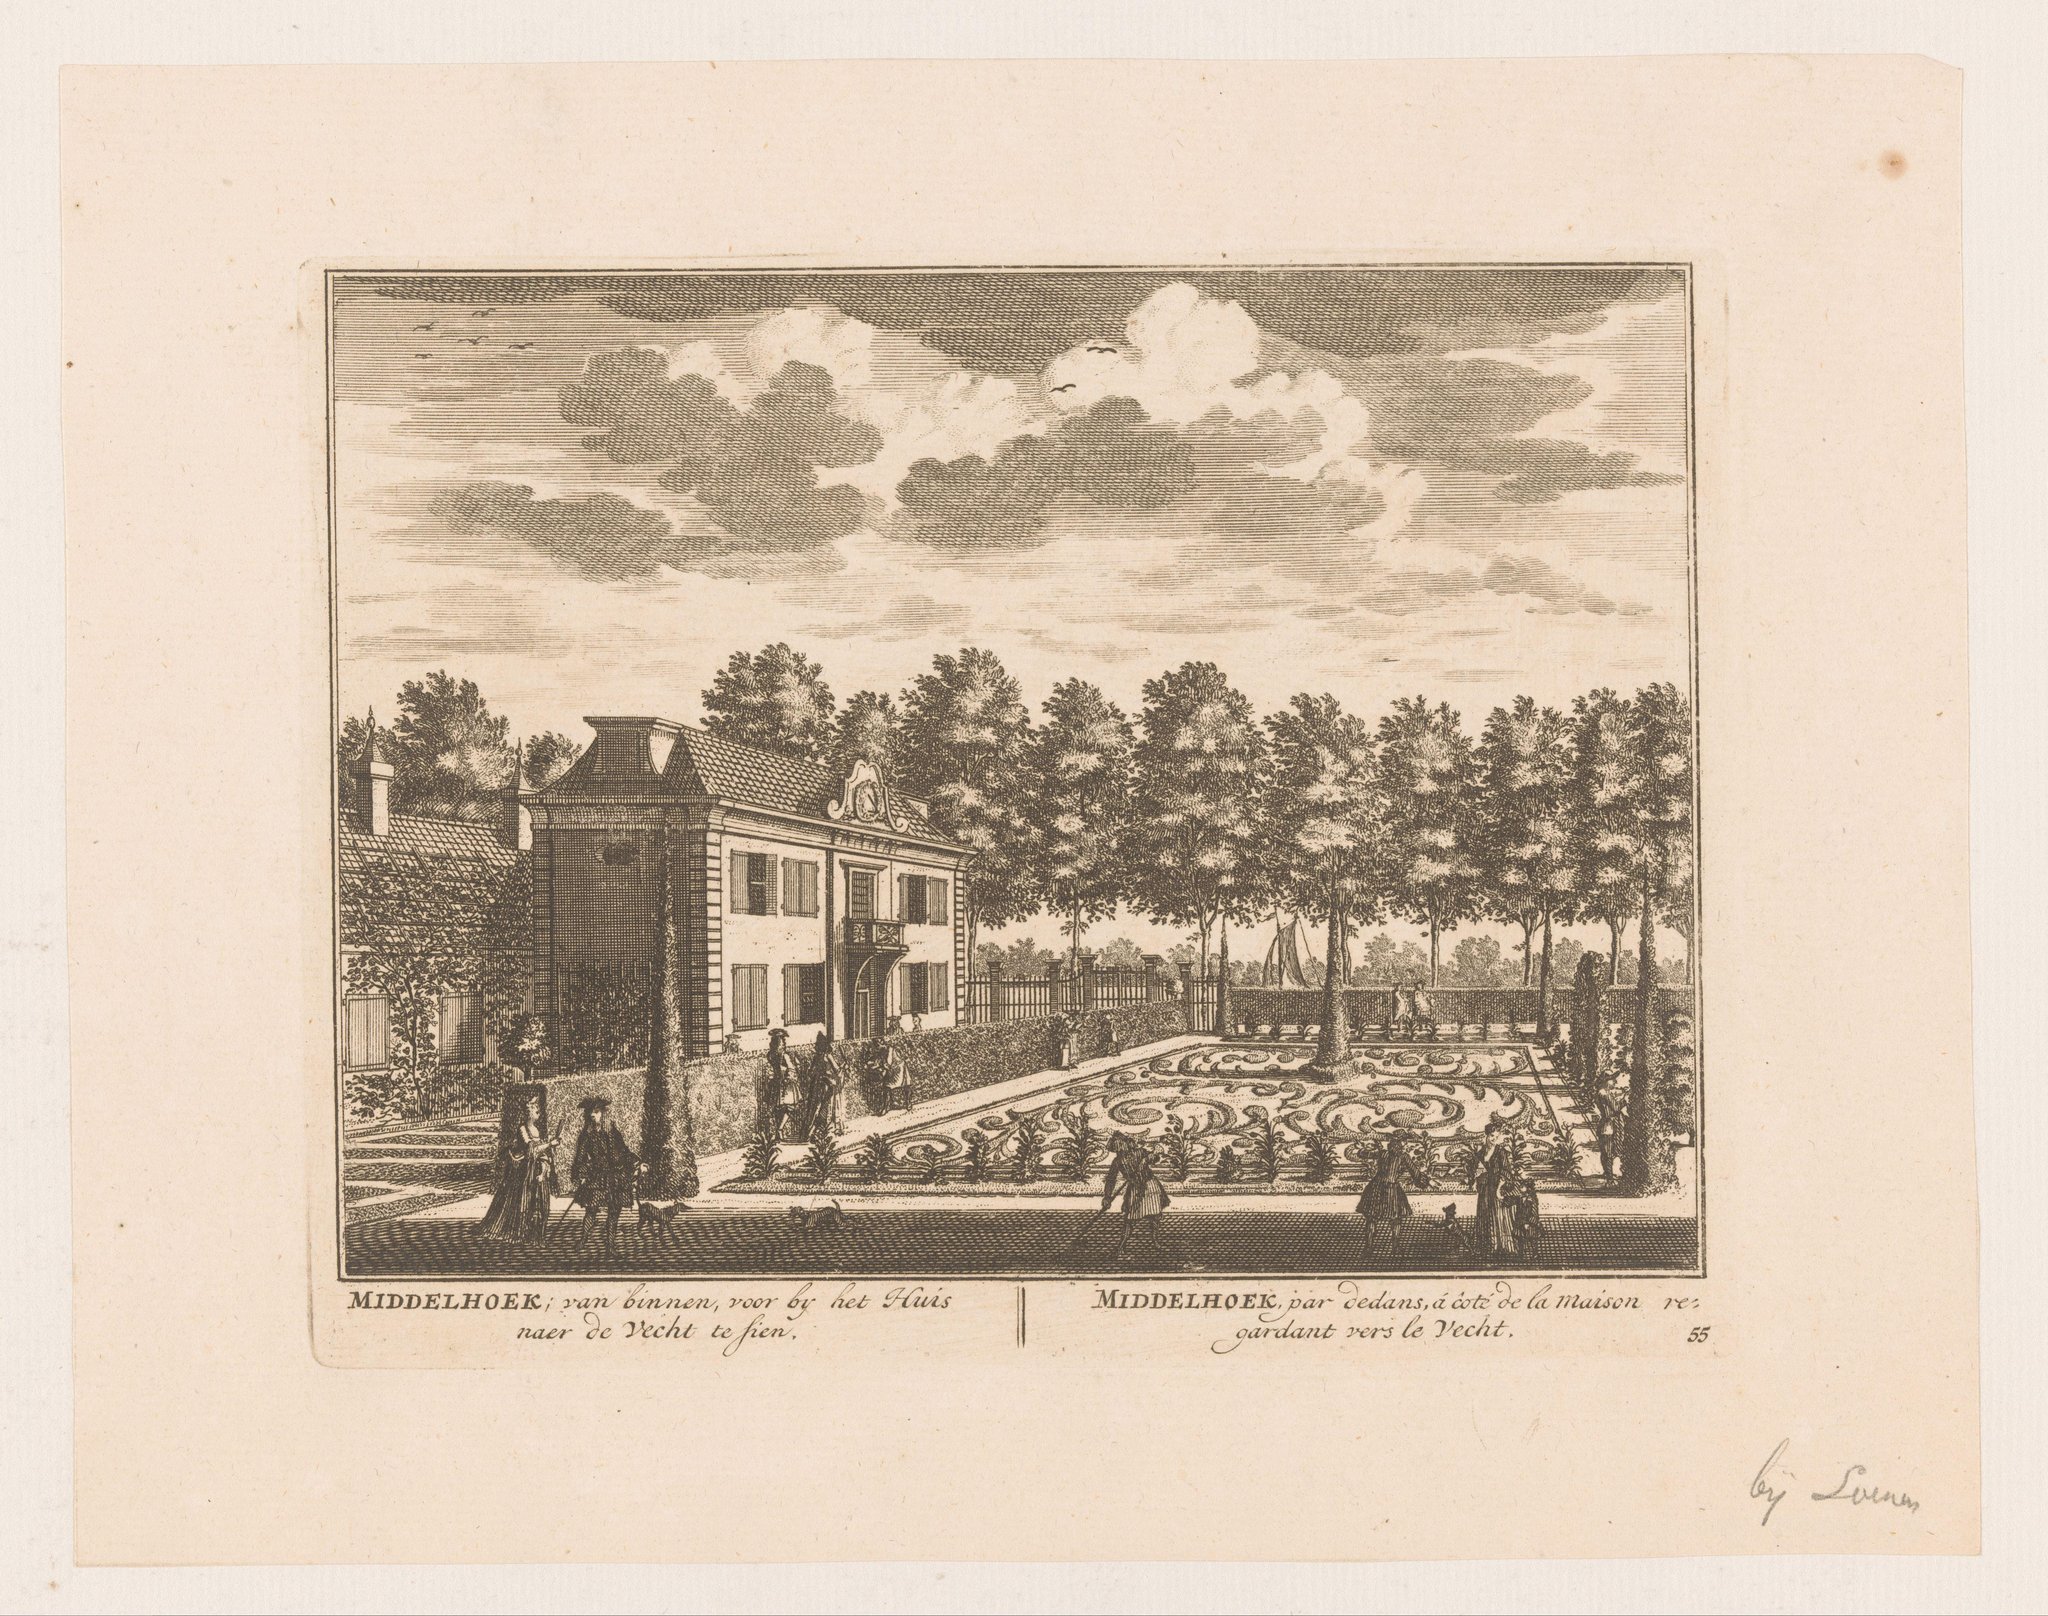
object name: print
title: Middelhoek; van binnen, voor by het Huis naer de Vecht te sien / Middelhoek, par dedans, á côte de la maison regardant vers le Vecht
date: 1719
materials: paper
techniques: etching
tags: rural housing, e.g. country-house, villa, cottage, french or architectonic garden; formal garden, vecht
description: Prent uit: De zegepraalende Vecht, vertoonende verscheidene gesichten van lustplaatsen, heeren huysen en dorpen, beginnende van Uitrecht en met Muyden besluytende. Amsterdam: Wed. Nicolaes Visscher, 1719.